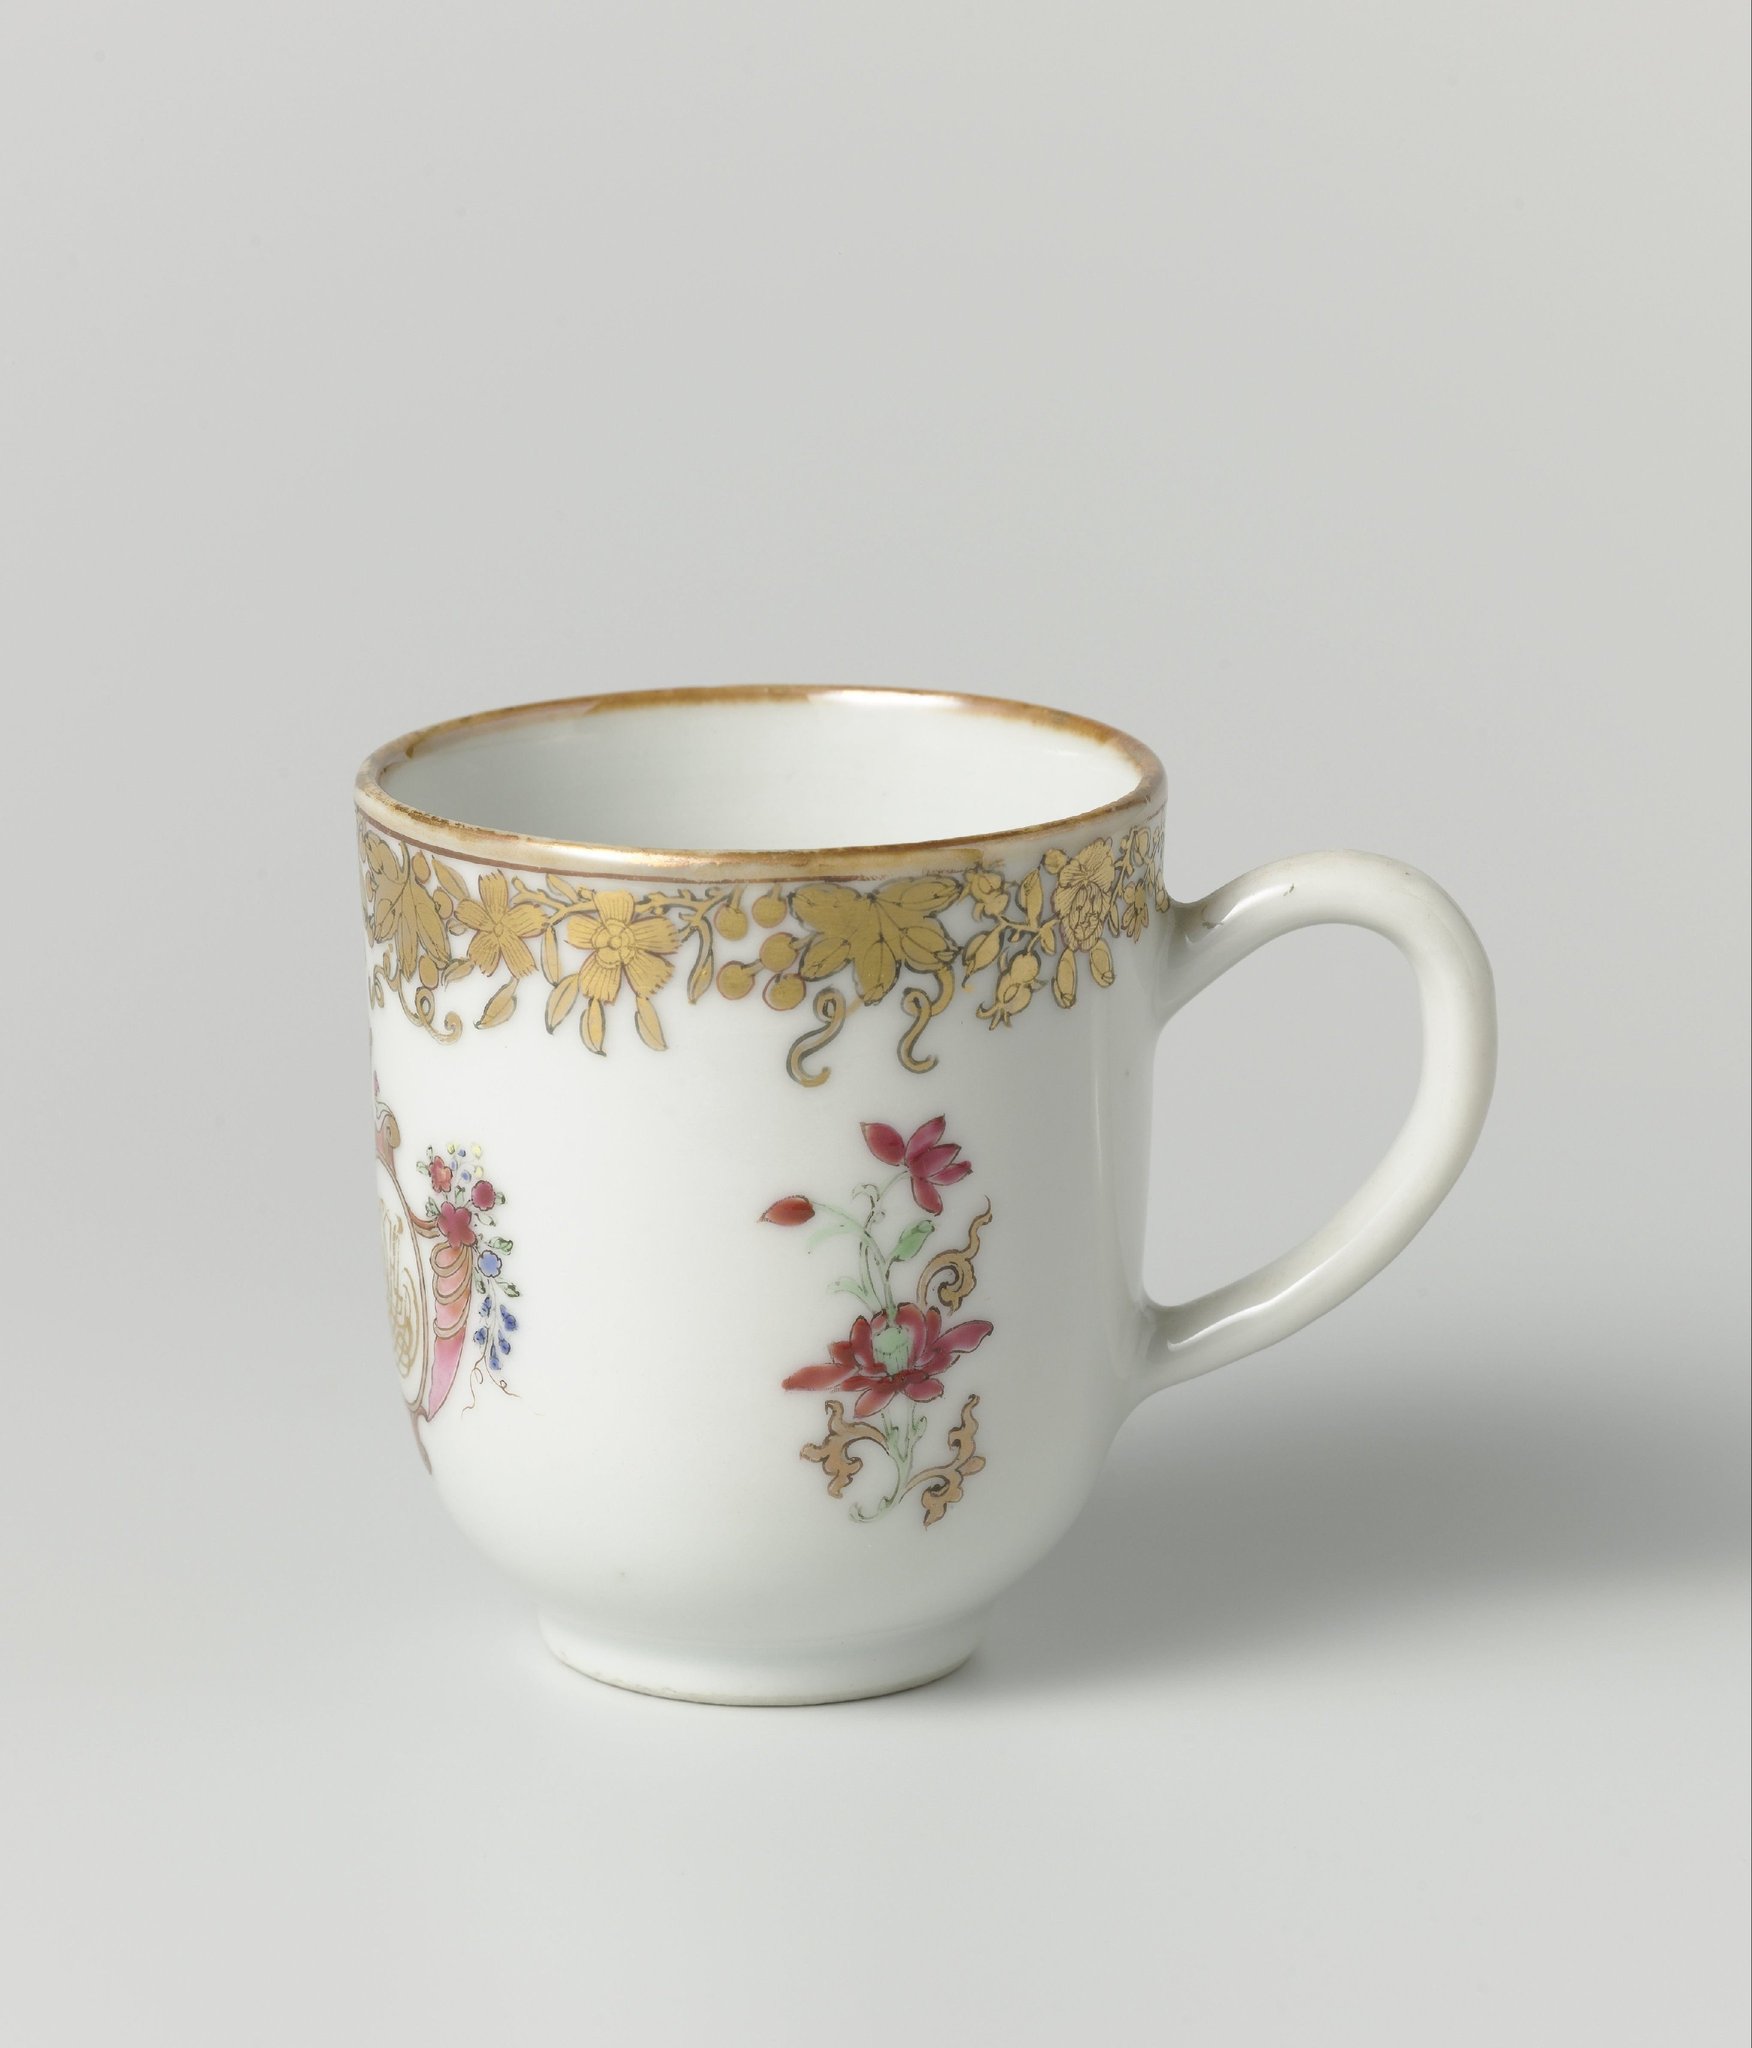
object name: oorkop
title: Cup with handle from the 'Swellengrebel service' with a double crowned monogram and a border with floral scrolls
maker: Anonymous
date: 1740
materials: glaze, gold, paint, porcelain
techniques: firing, gilding, turning, vitrification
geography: china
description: De monogrammen 'MVA' en 'CHTD' staan voor Maurits van Aerden (1694-1746) en Constantia Helena ten Damme (1694-1772), getrouwd in 1716. Het servies is waarschijnlijk besteld ter ere van hun vijfentwingtigjarig huwelijksjubileum in 1741. (Campen, Jan van & Hartkamp-Jonxis, Ebeltje, Aziatische weelde : VOC-kunst in het Rijksmuseum, Zutphen 2011, p. 78)